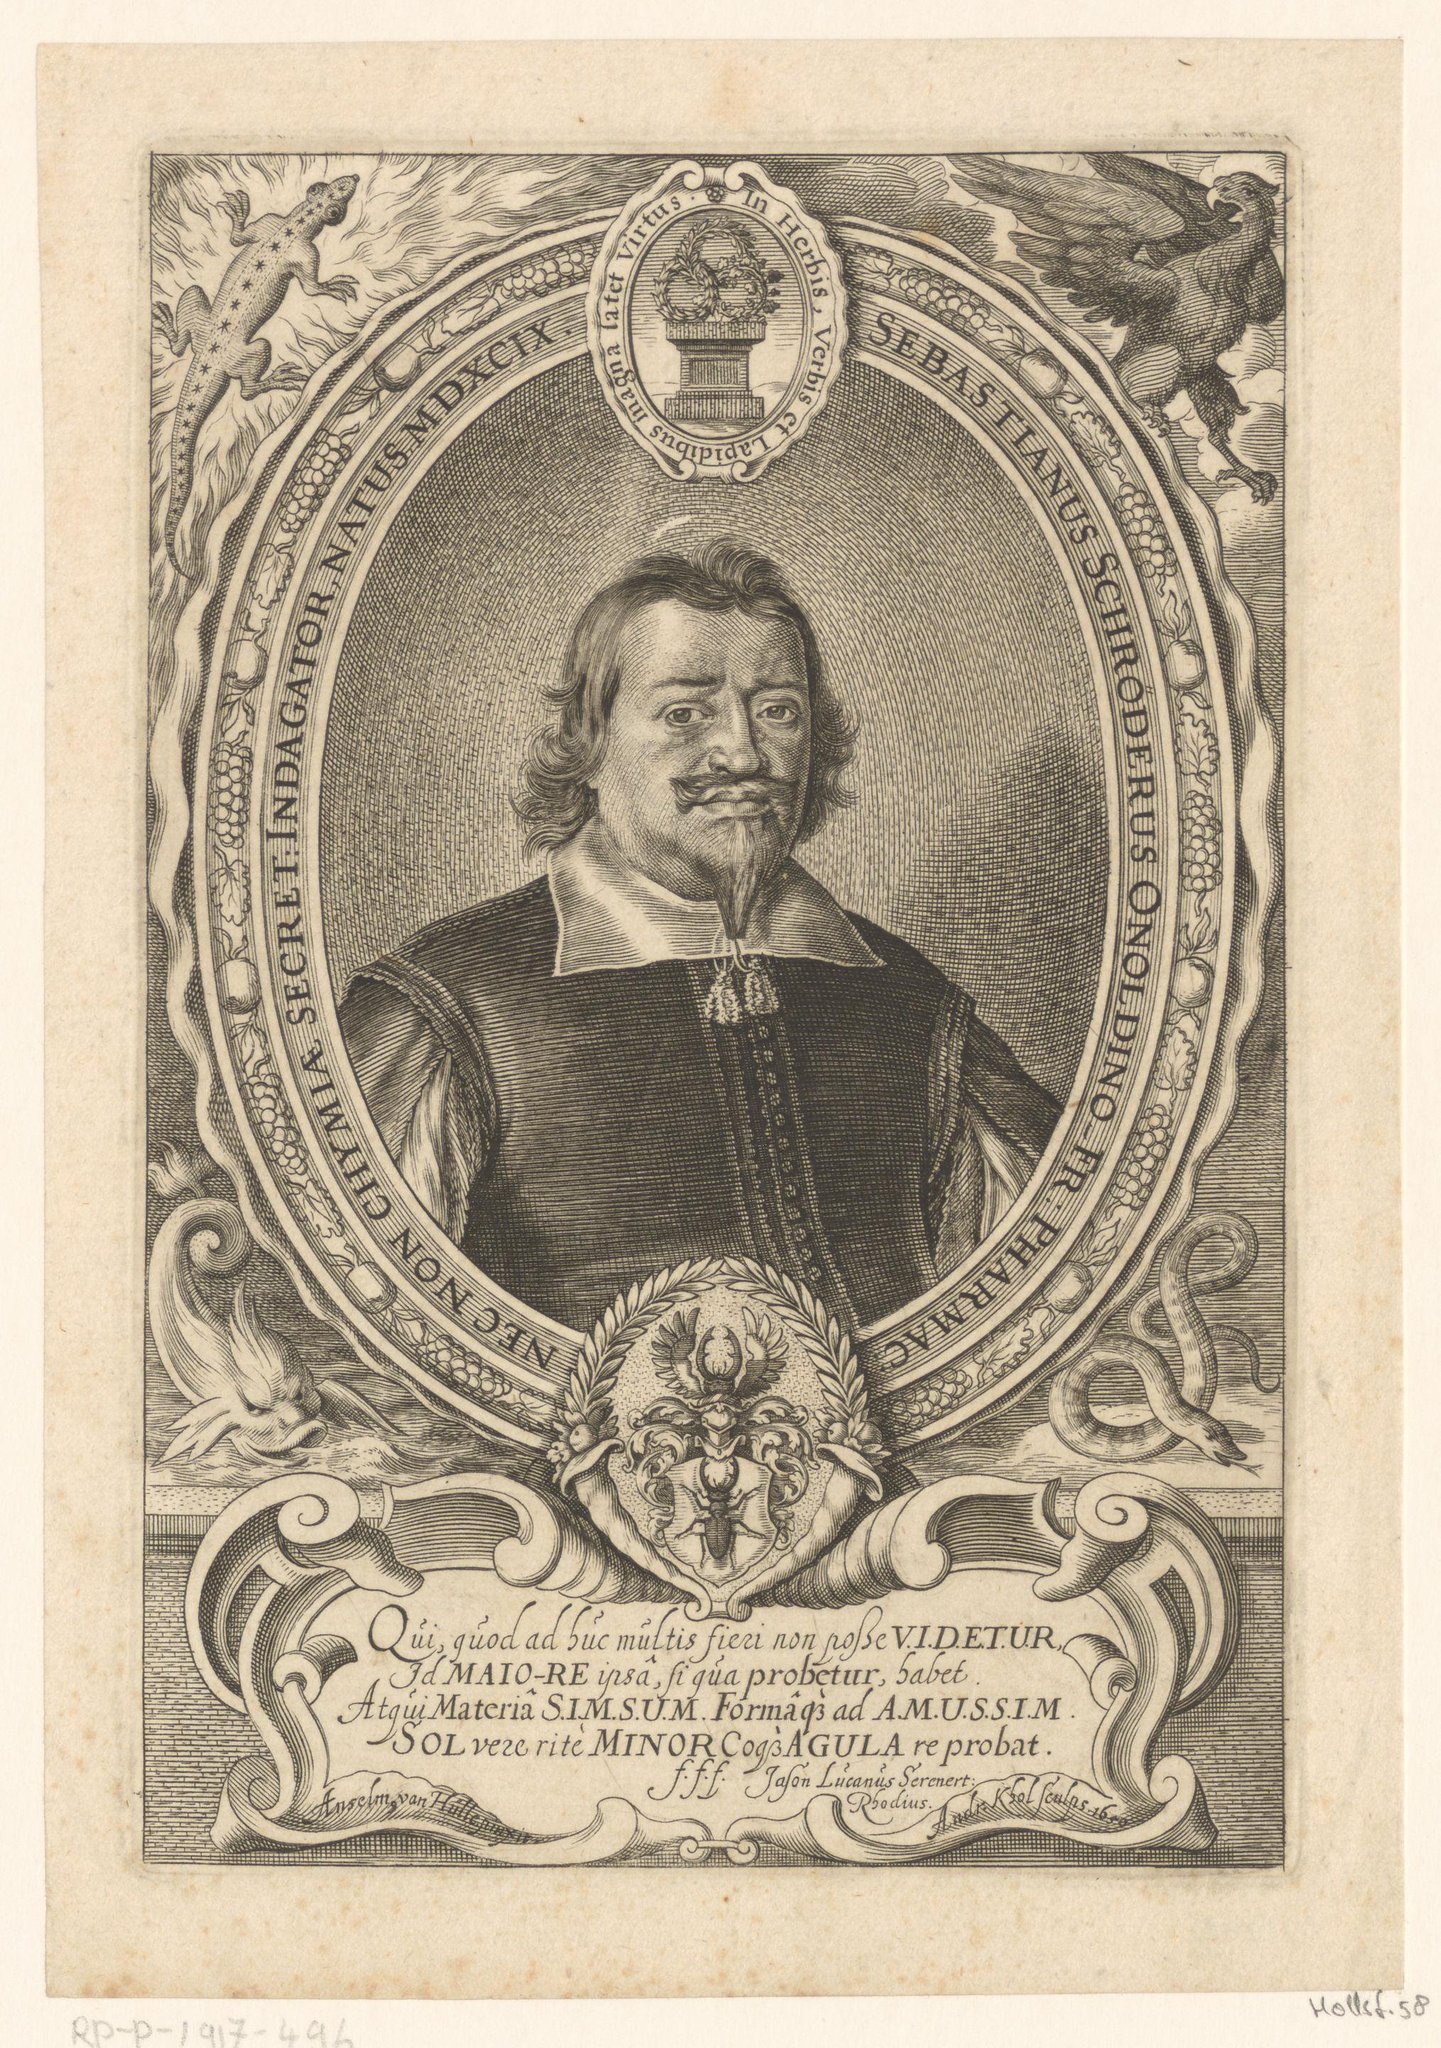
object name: print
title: Portret van Sebastian Schröder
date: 1650-1657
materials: paper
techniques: engraving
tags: pharmacist, druggist, apothecary; pharmacy, drugstore, dispensing chemist (+ portrait of scholar, scientist), historical persons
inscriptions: collector's mark: Lugt 2228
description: Tekst in het Latijn in de omlijsting en in de cartouche.